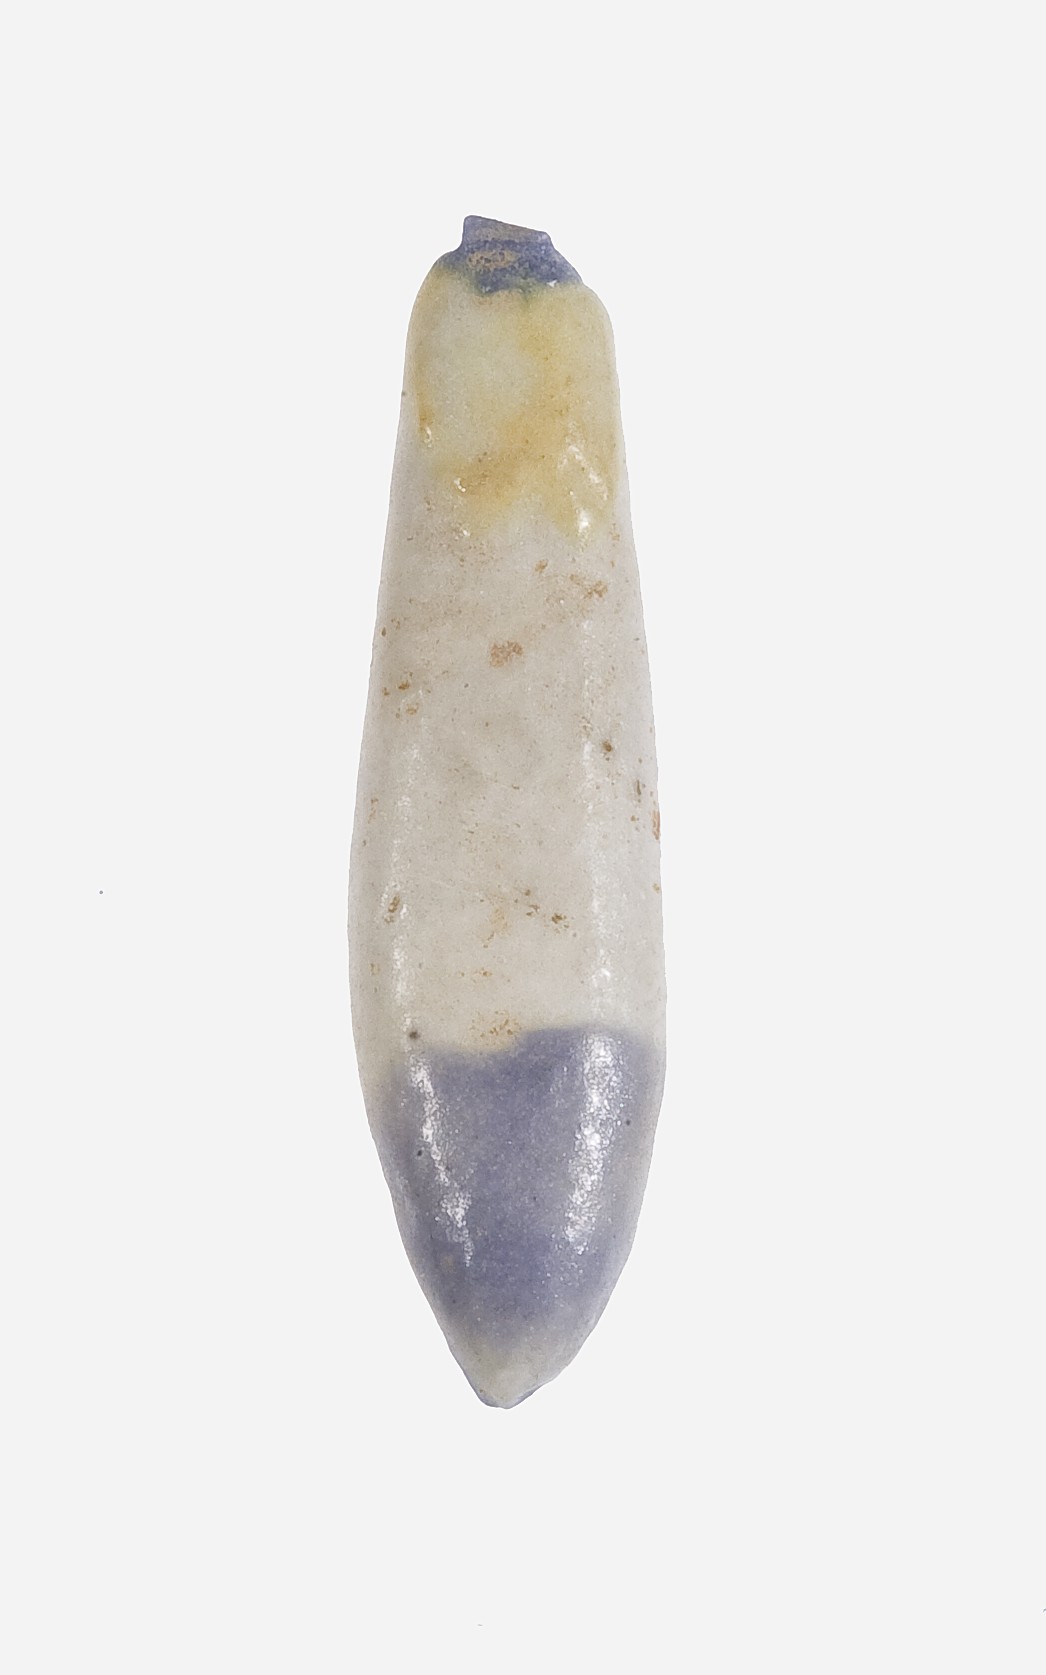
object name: bead, lotus petal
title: Bead in the Form of a Lotus Petal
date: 1390-1352 BCE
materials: faience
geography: egypt